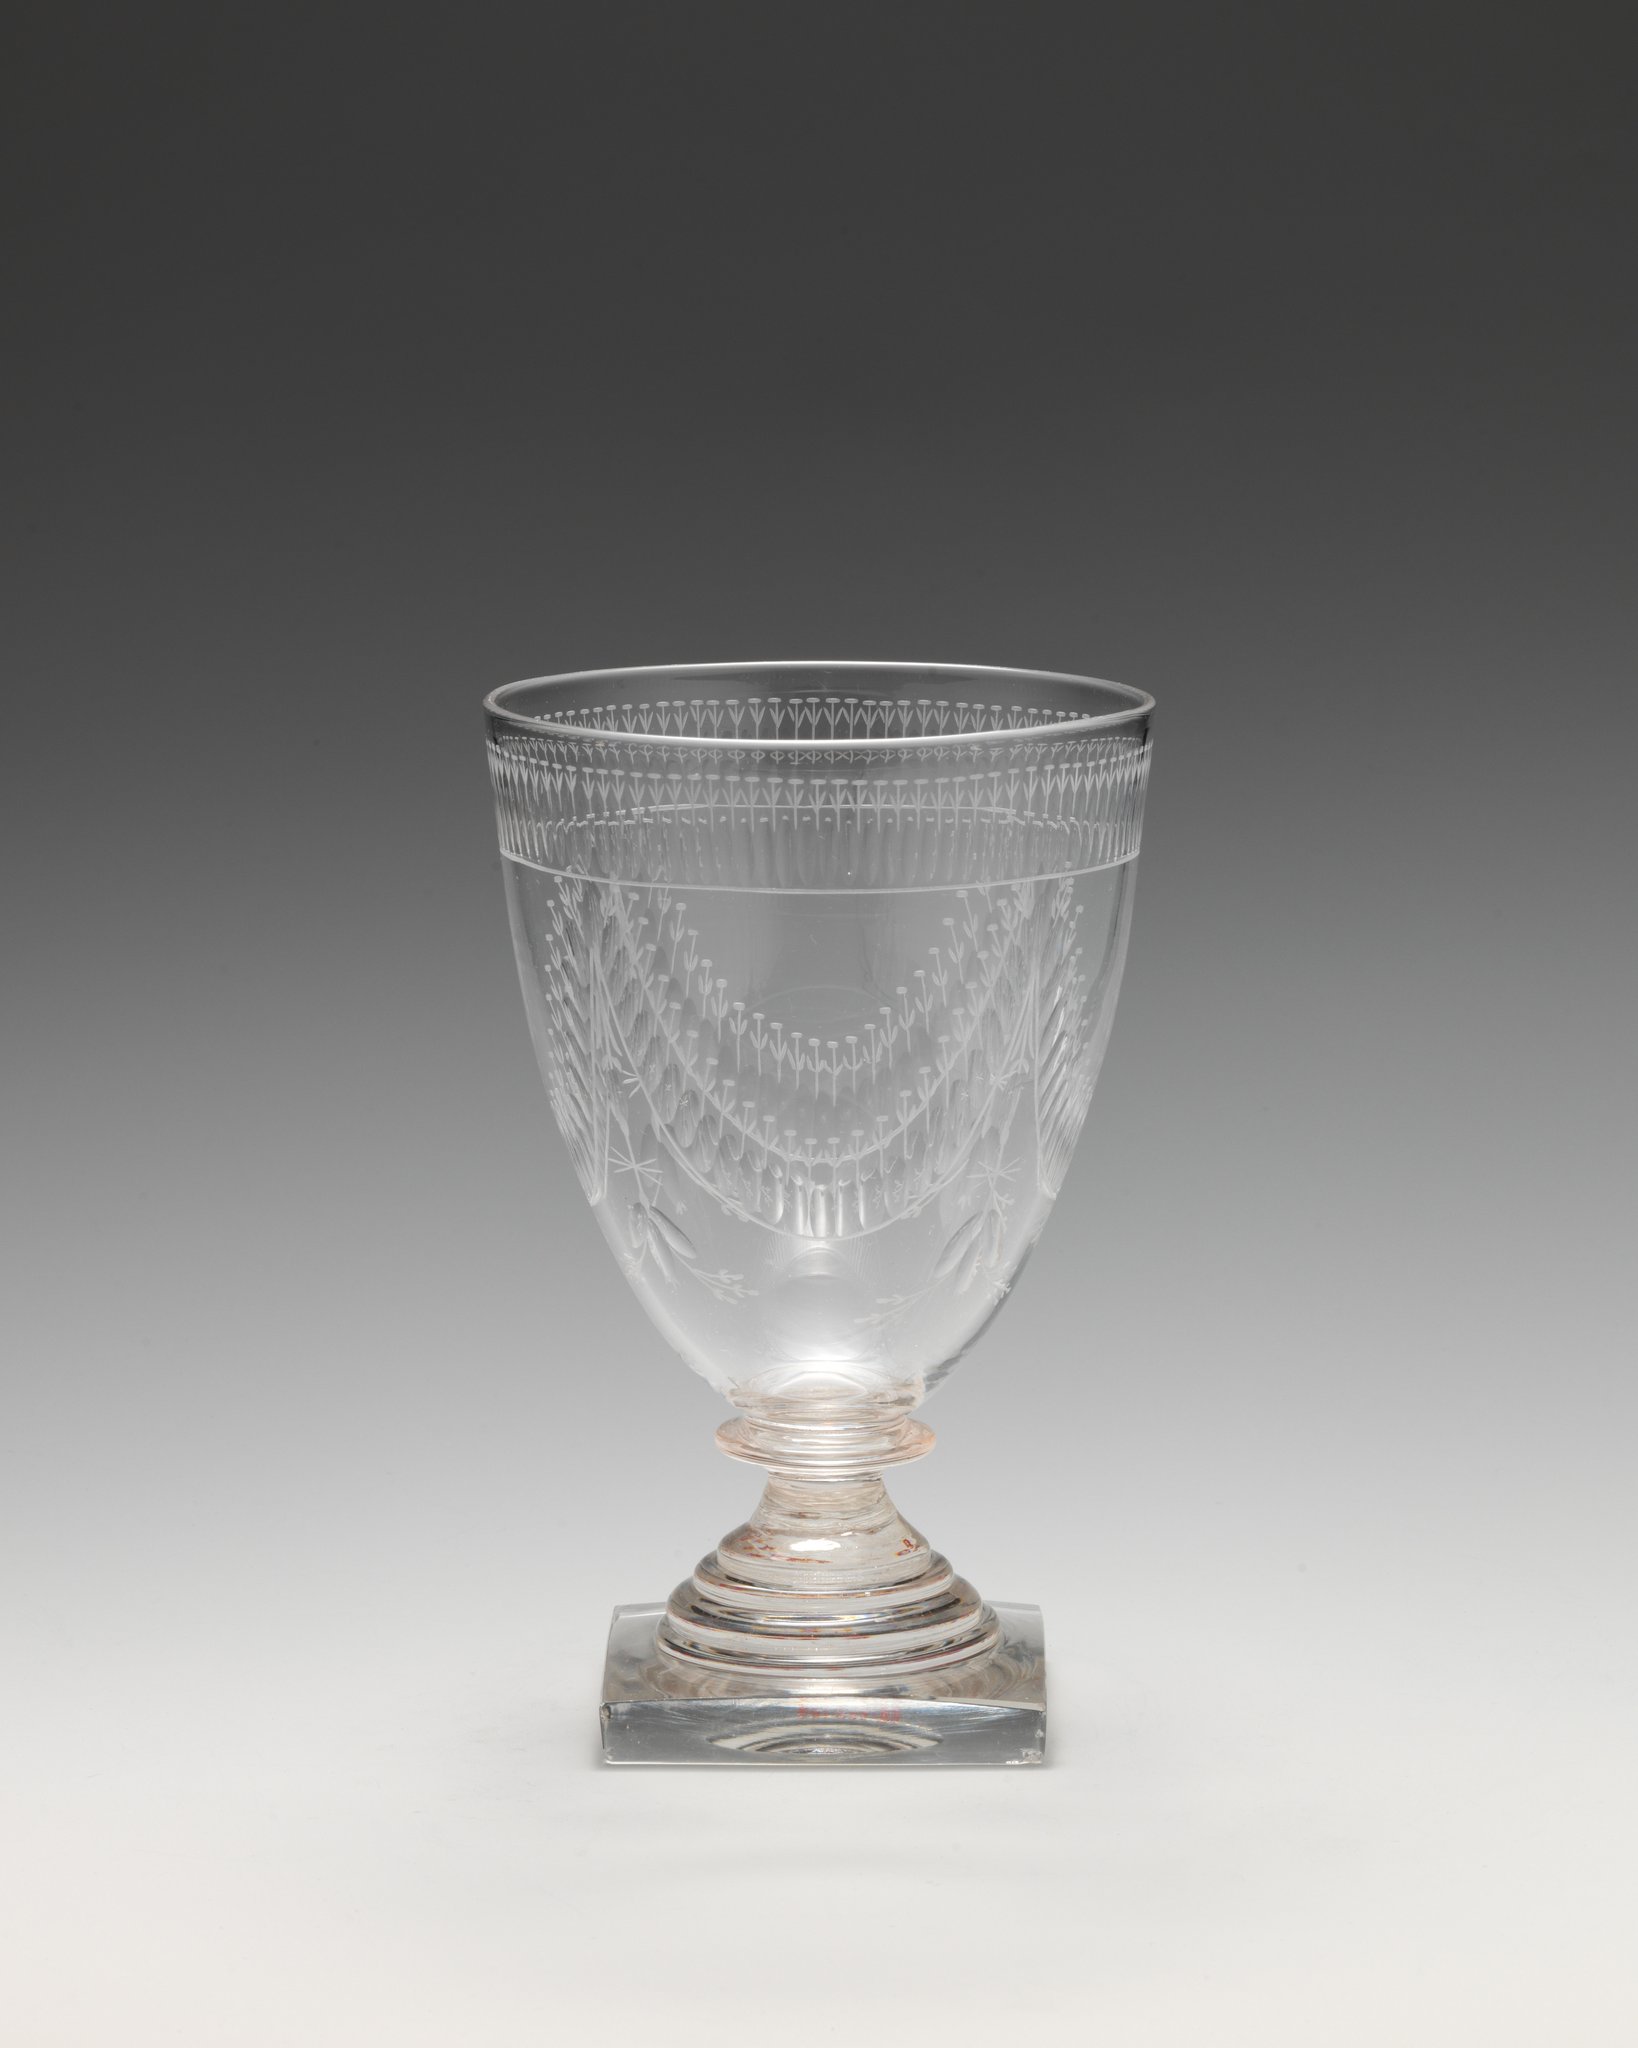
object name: goblet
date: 1801-1833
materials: glass